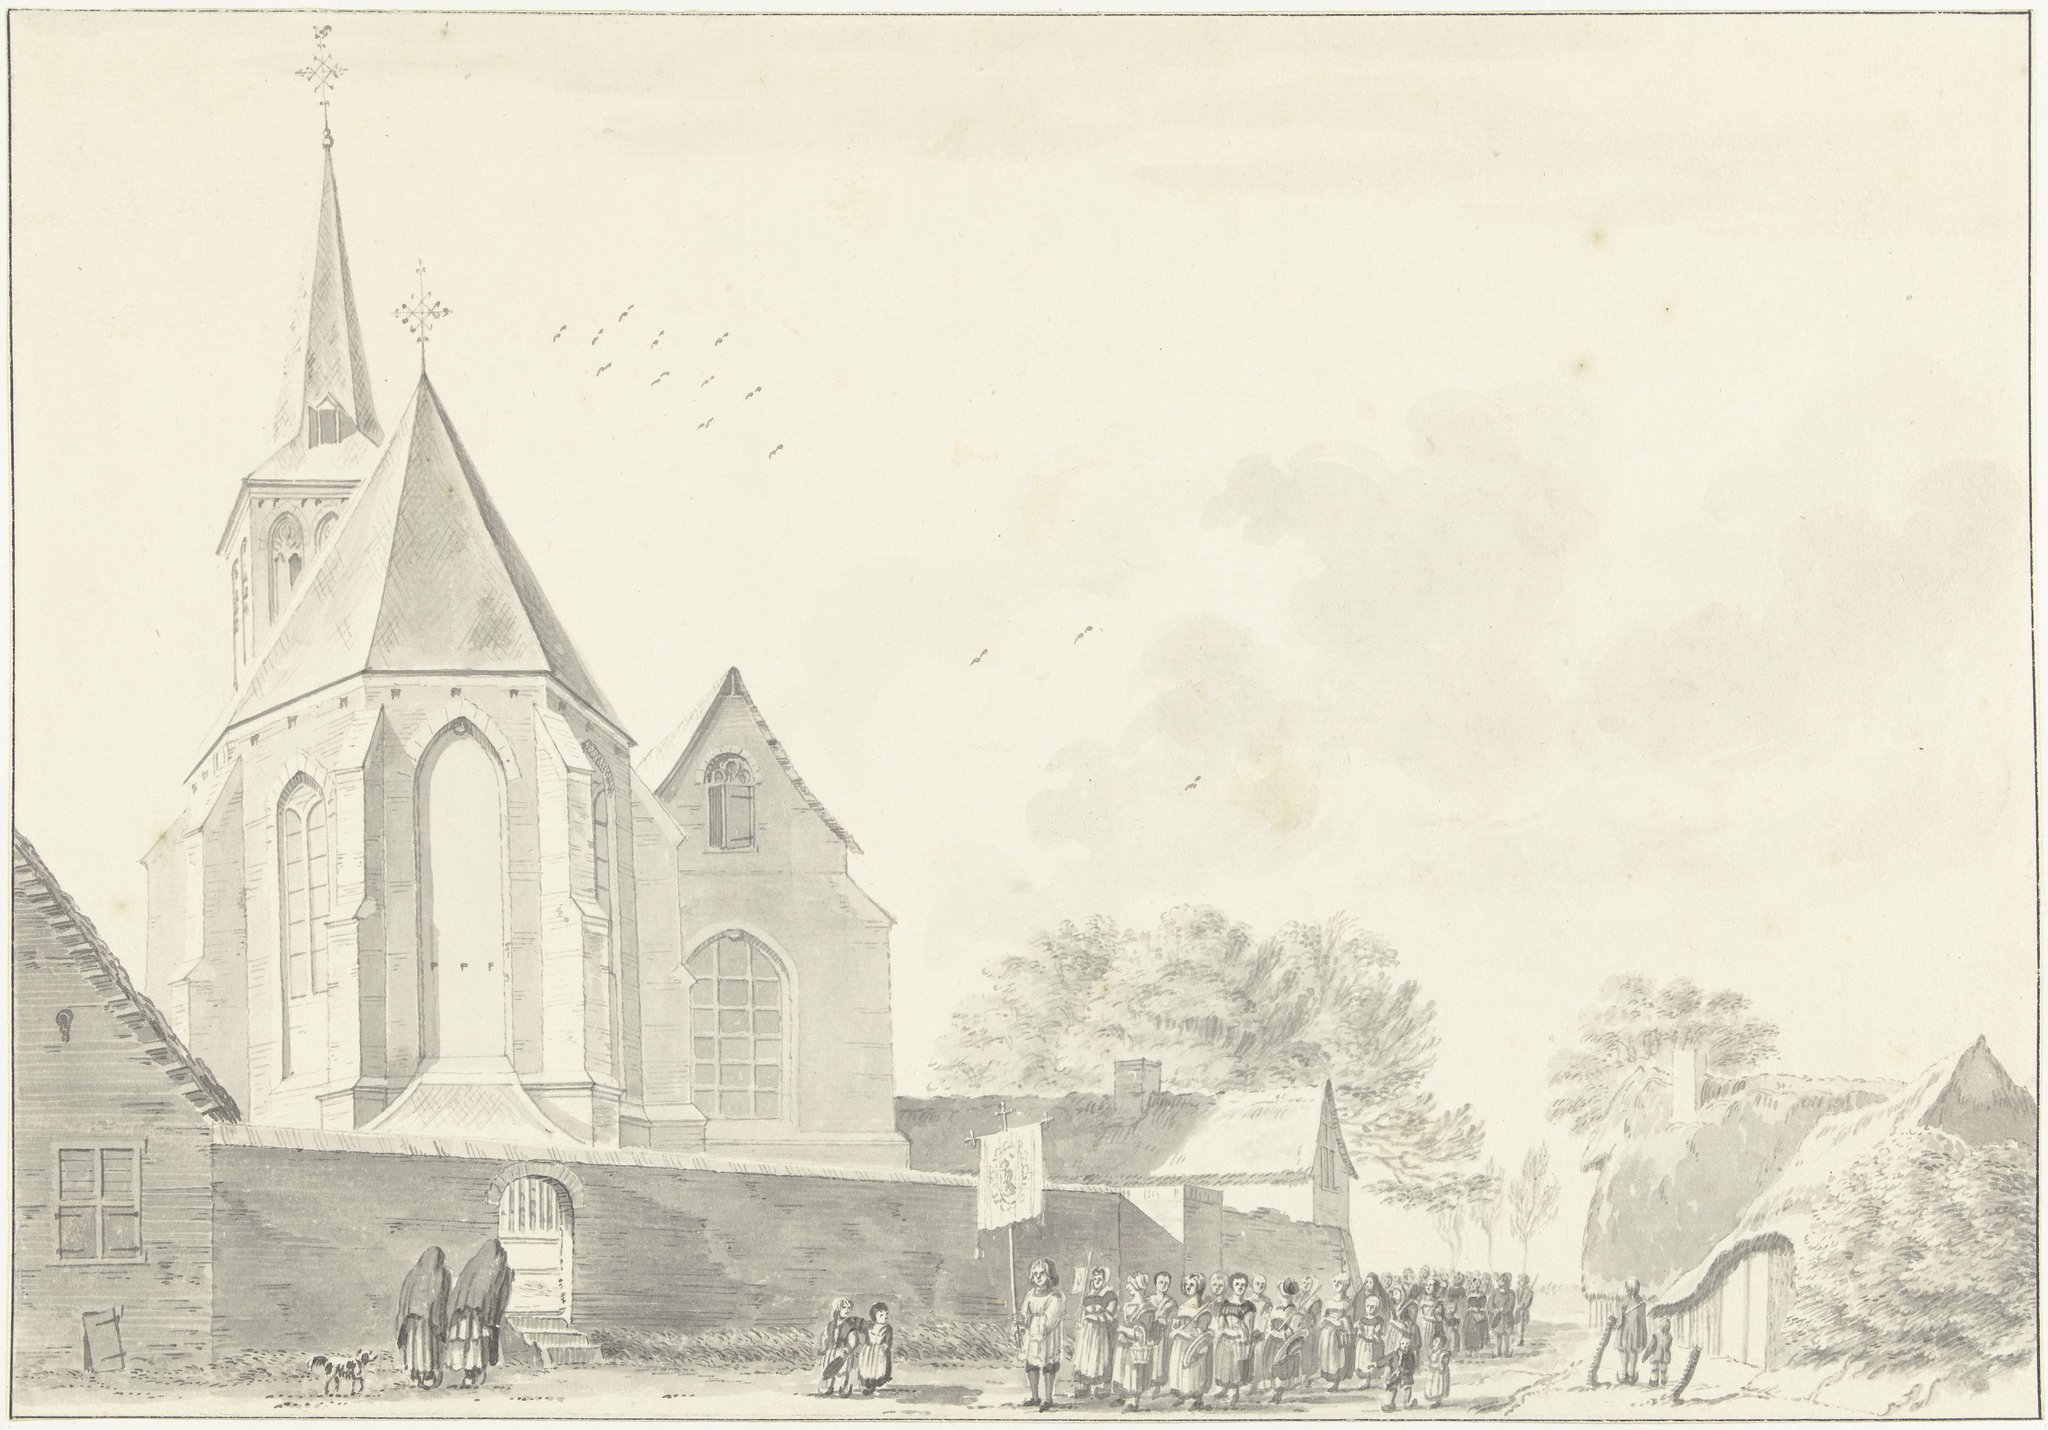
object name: drawing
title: Processie langs de kerk van Broekhuizenvorst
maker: jan de beijer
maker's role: draughtsman, print maker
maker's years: 1703-1780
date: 1713-1780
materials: ink, paper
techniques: brush, pen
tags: church (exterior)